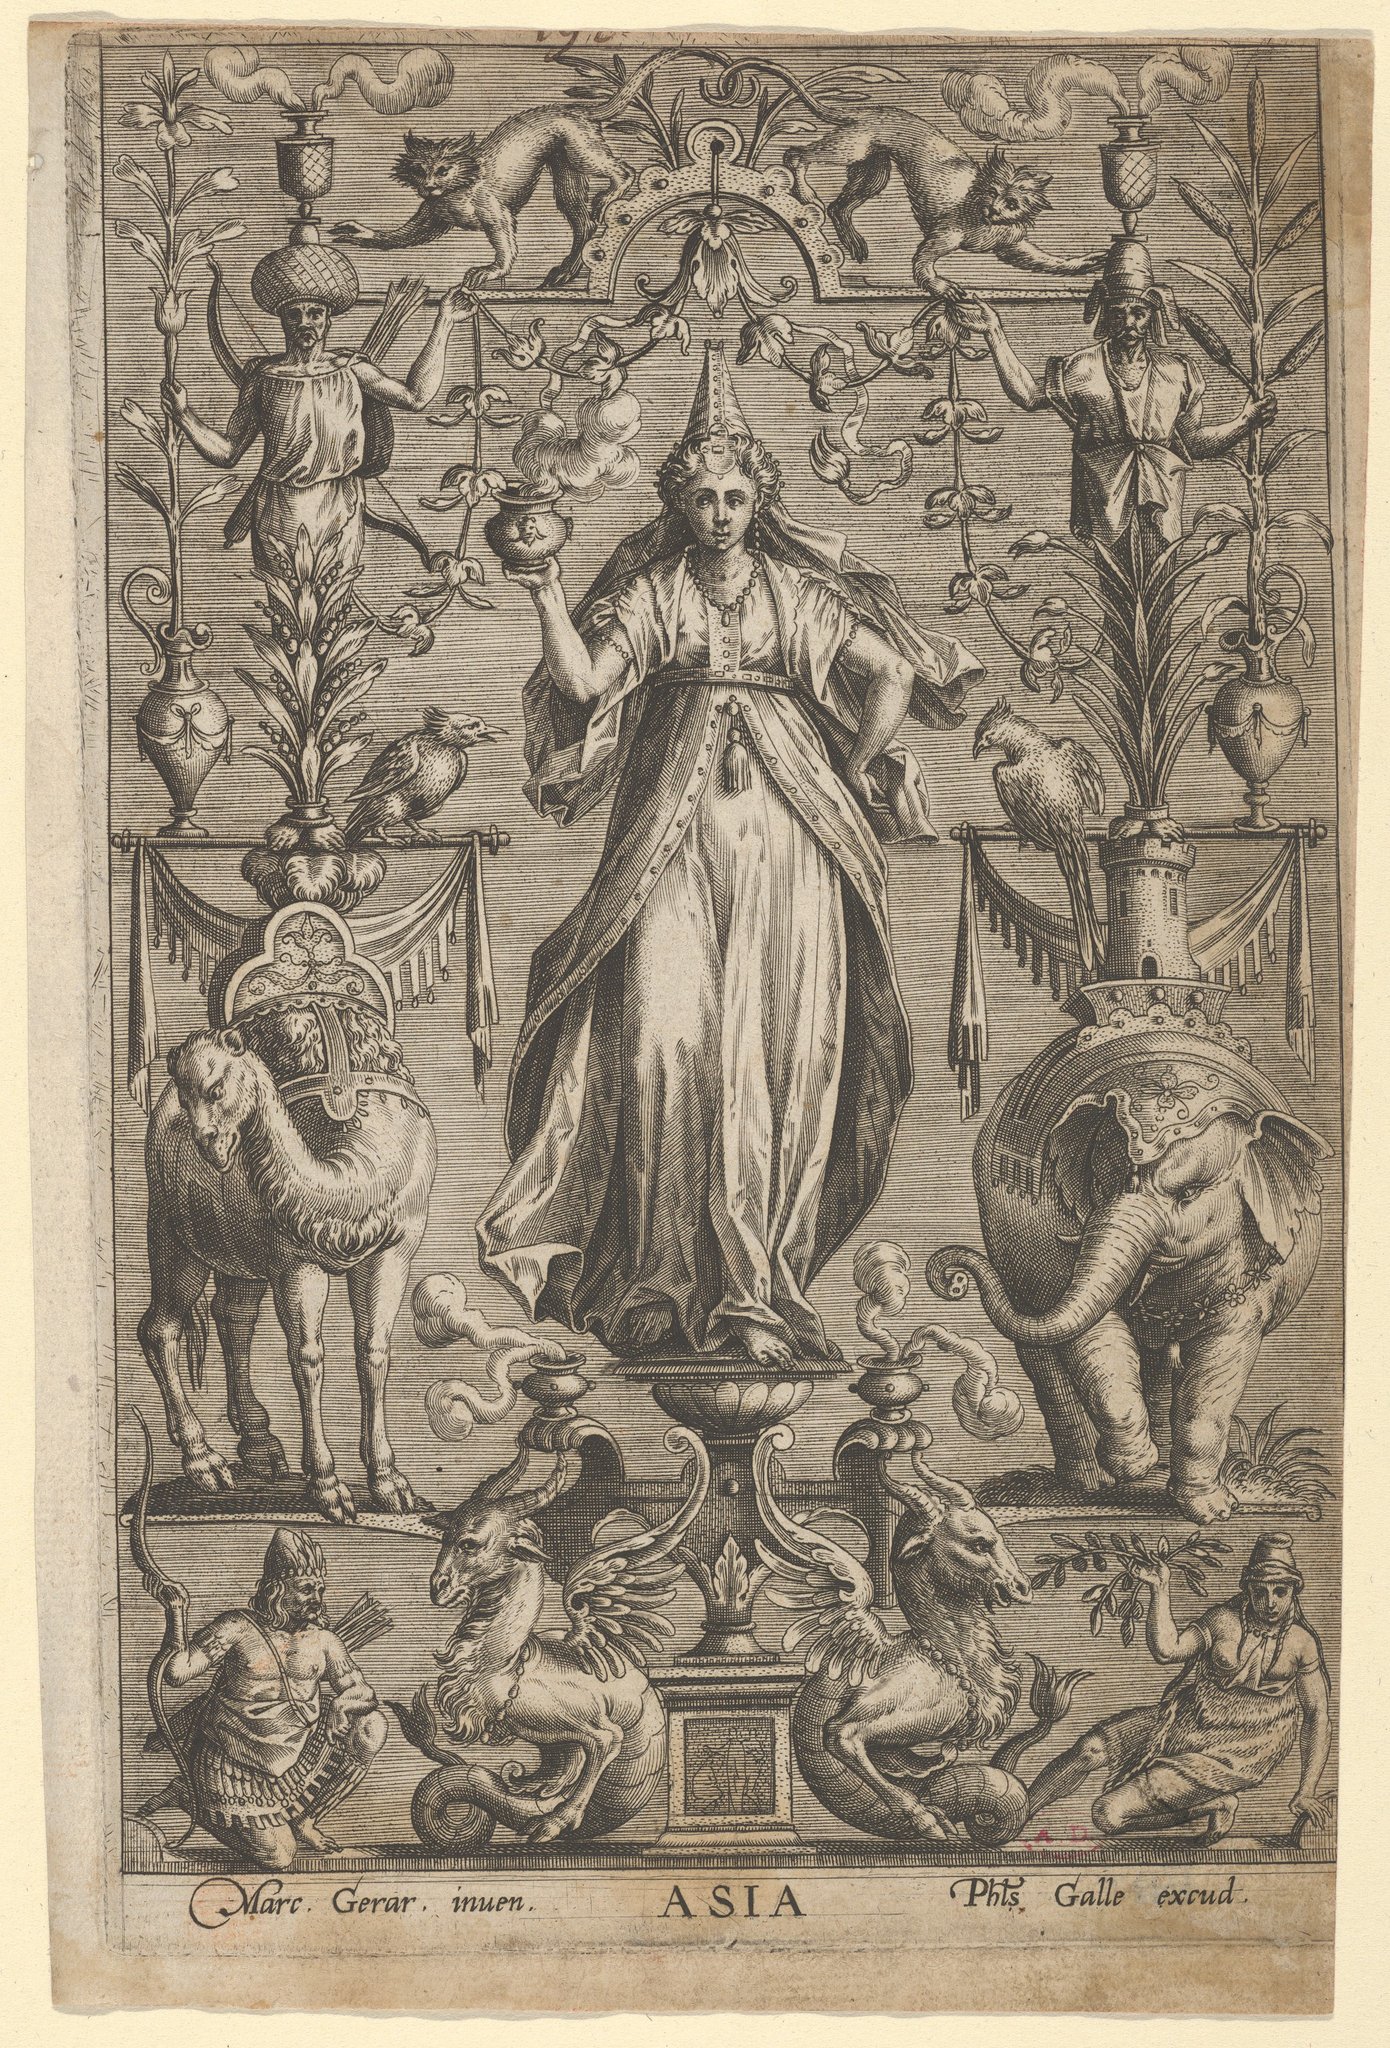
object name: print ornament architecture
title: Allegory of Asia, from "The Four Continents"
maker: marcus gheeraerts the elder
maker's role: artist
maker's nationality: flemish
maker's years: 1510-1600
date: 1590-1600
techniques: engraving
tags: birds,women,camels,elephants